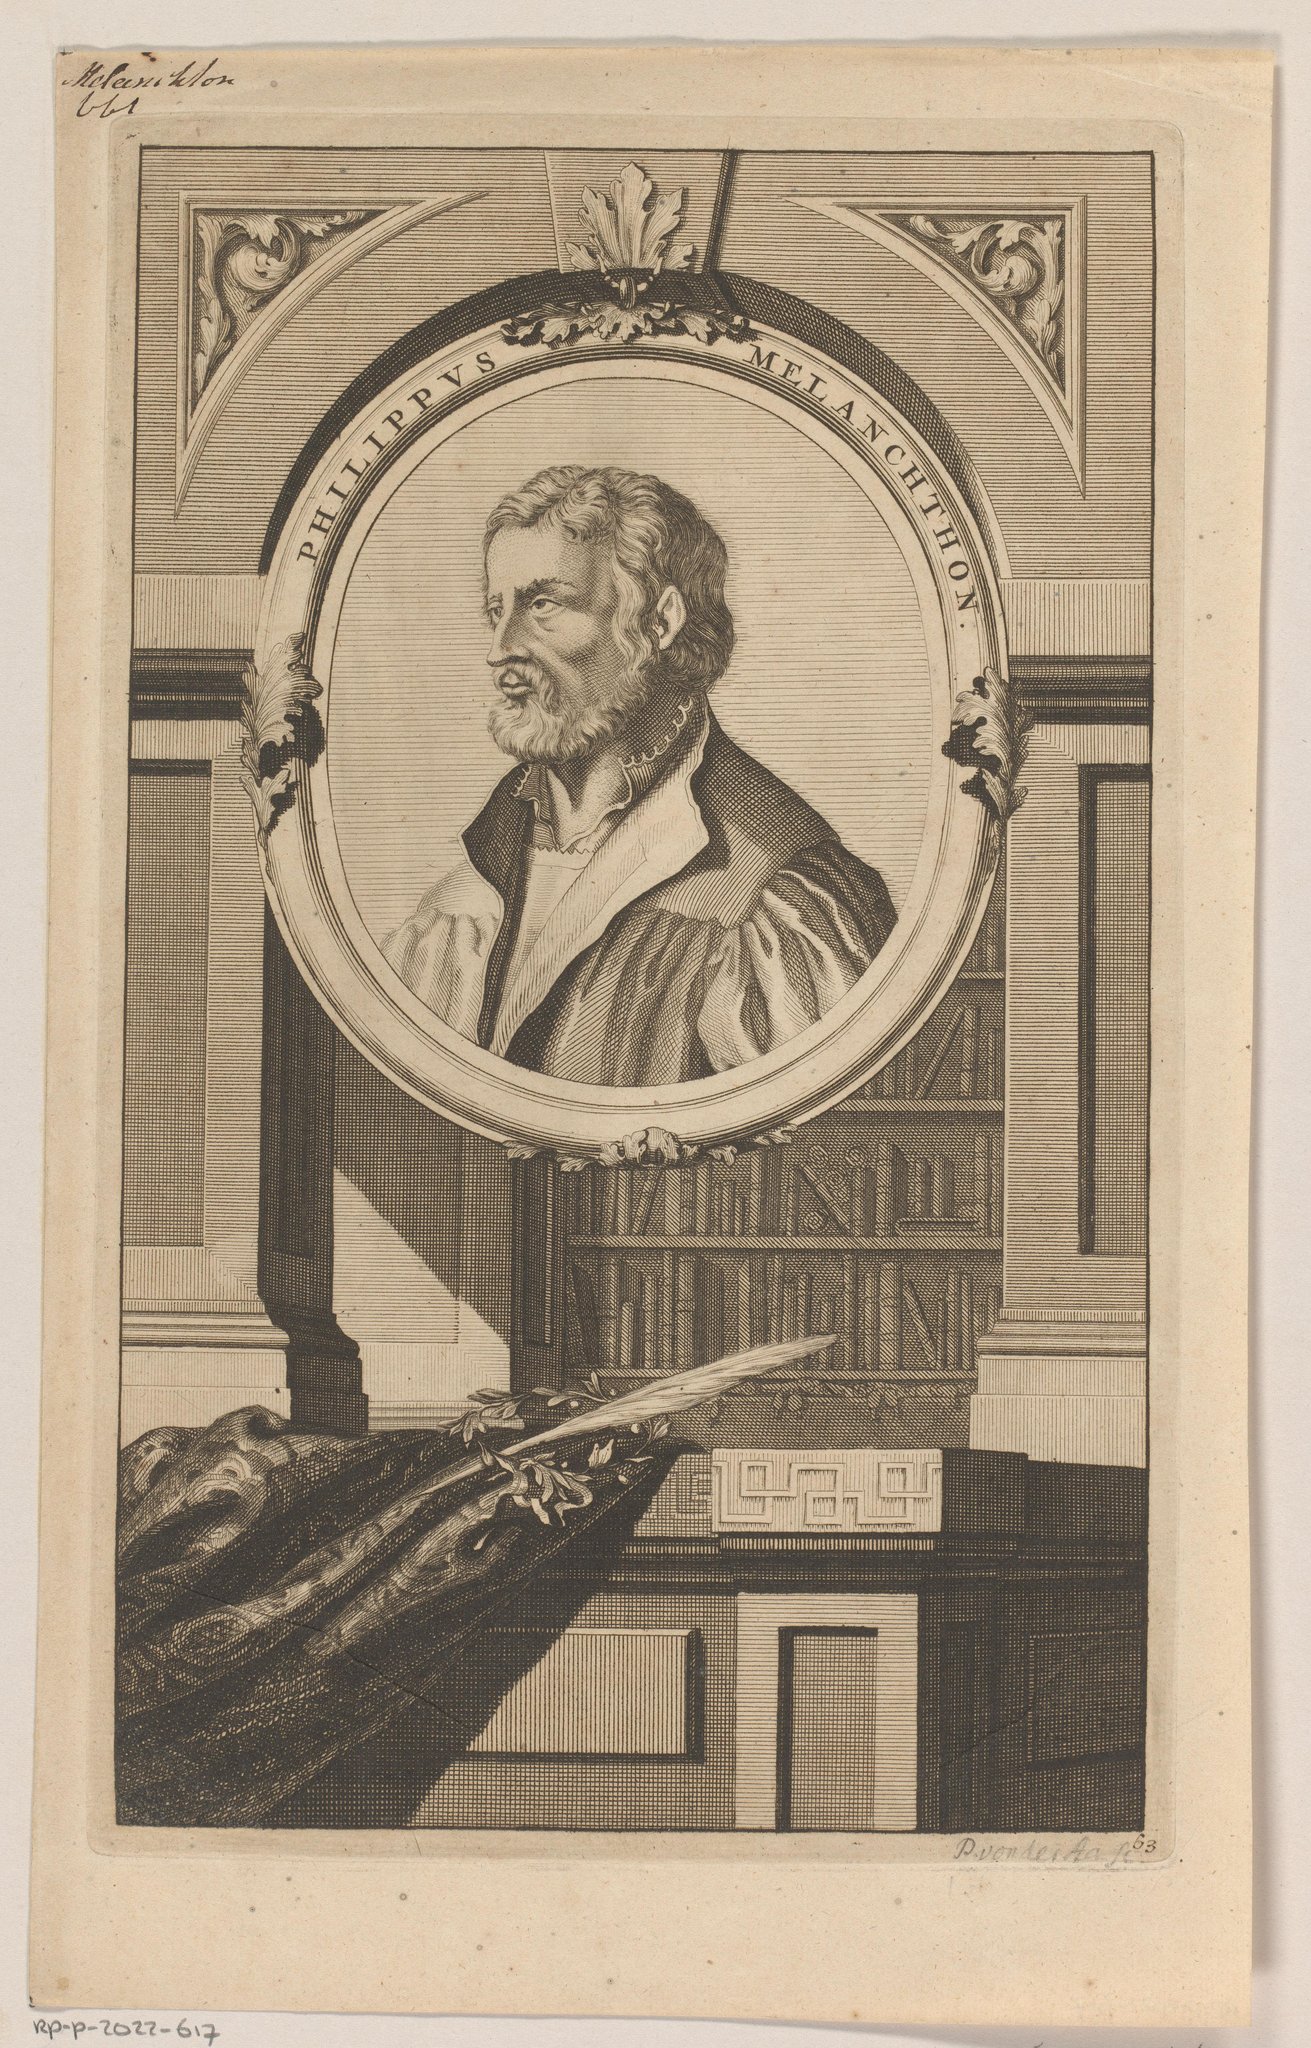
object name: book illustration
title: Philippus Melanchthon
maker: Anonymous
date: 1700-1800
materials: paper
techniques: engraving, etching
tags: theologian, historical persons